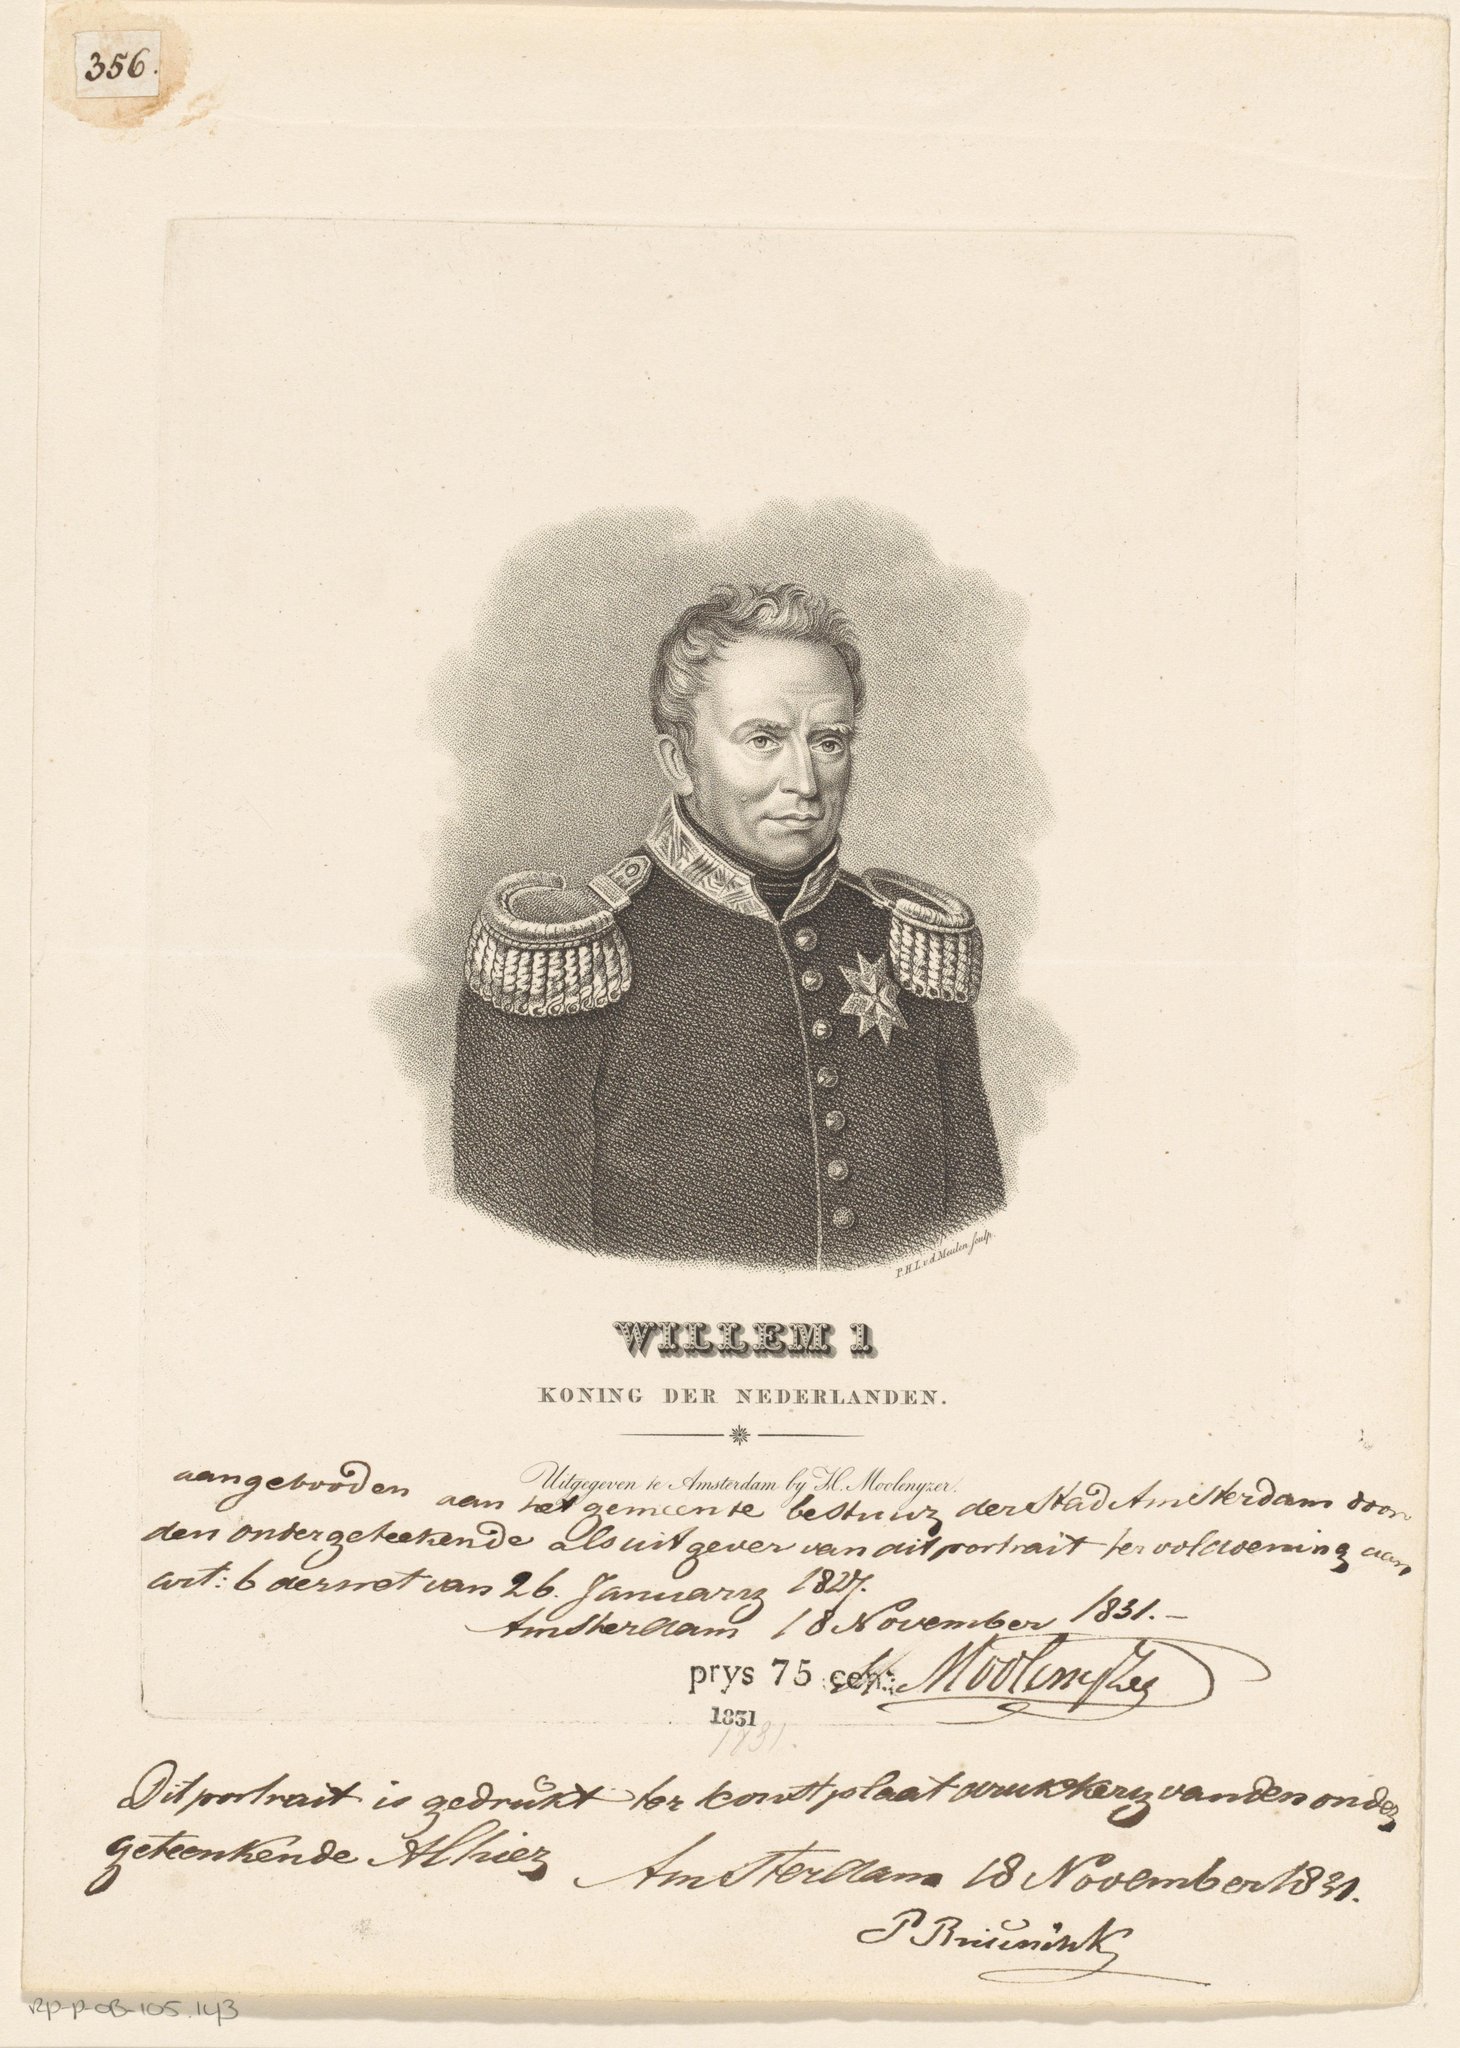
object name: print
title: Portret van Willem I Frederik, koning der Nederlanden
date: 1815-1847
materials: paper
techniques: engraving, etching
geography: amsterdam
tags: the hague, berlin, william i of the netherlands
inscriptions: stamp: ‘prys 75 cent’, : ‘aangebooden aan het gemeente bestuur der Stad Amsterdam ... Amsterdam 18 November 1831. Moolenyzer’, stamp: ‘1831’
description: De hier vermelde titel verwijst naar de hoogst verkregen titel van de geportretteerde, niet per se naar de titel die de geportretteerde op deze voorstelling draagt.